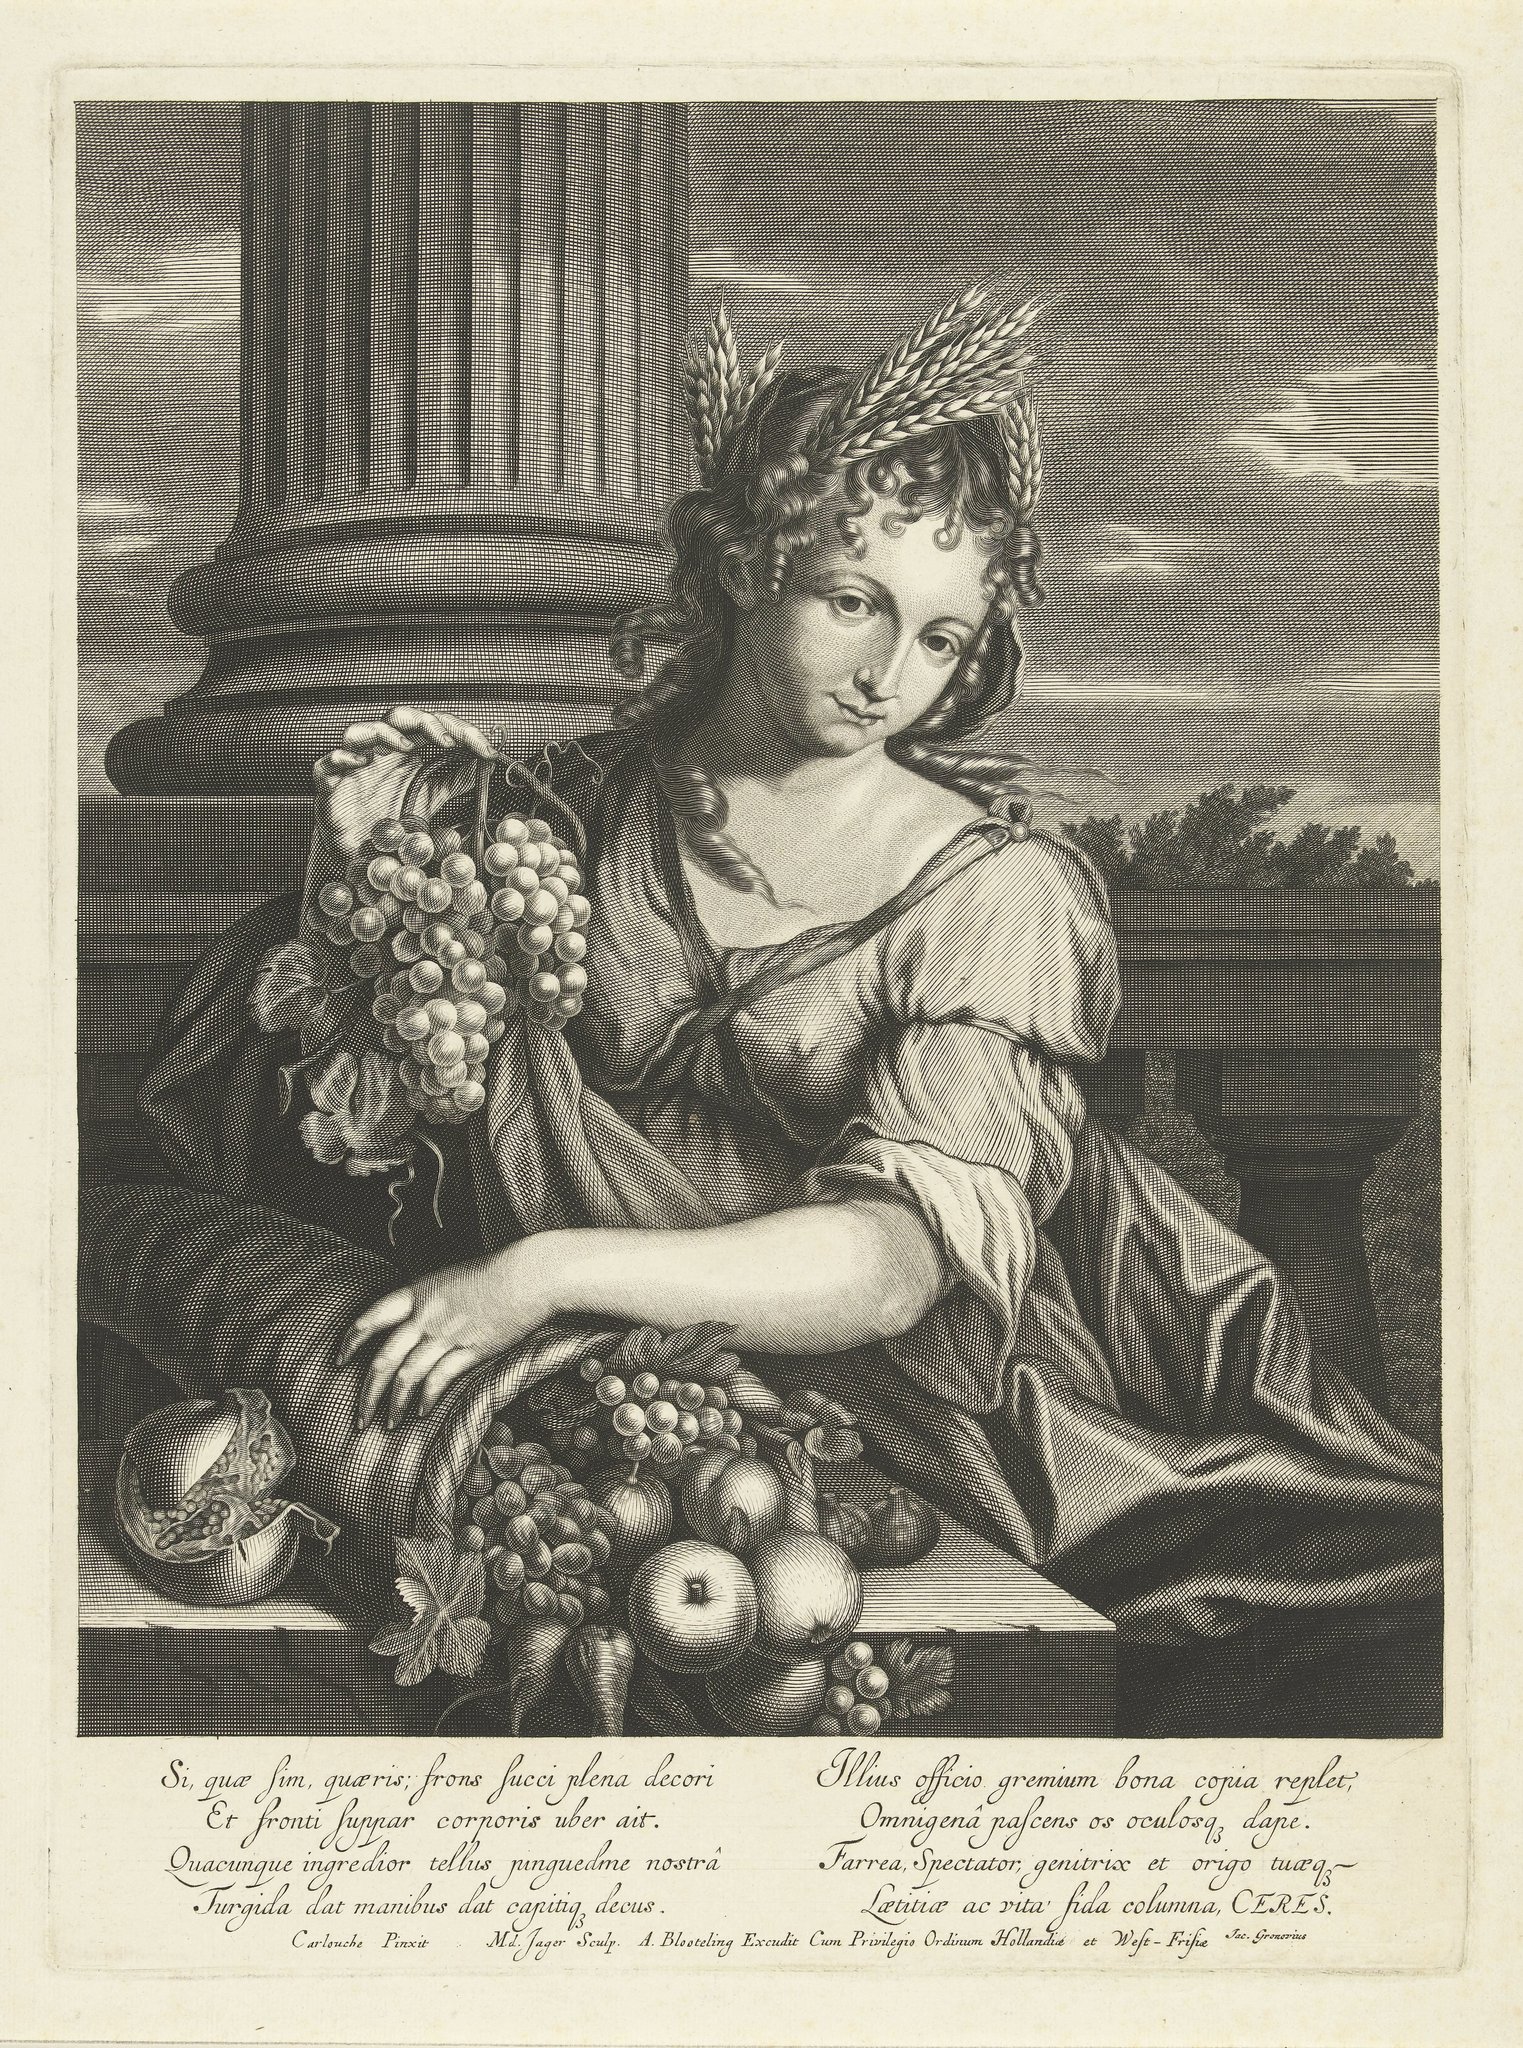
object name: print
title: Ceres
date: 1663-1684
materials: paper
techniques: engraving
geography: amsterdam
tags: ceres, patroness of agriculture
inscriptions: collector's mark: Lugt 2228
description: Ceres zittend voor een zuil. In haar rechterhand houdt ze een tros druiven en haar linkerhand rust op een hoorn des overvloeds. In de marge een achtregelig gedicht in het Latijn.